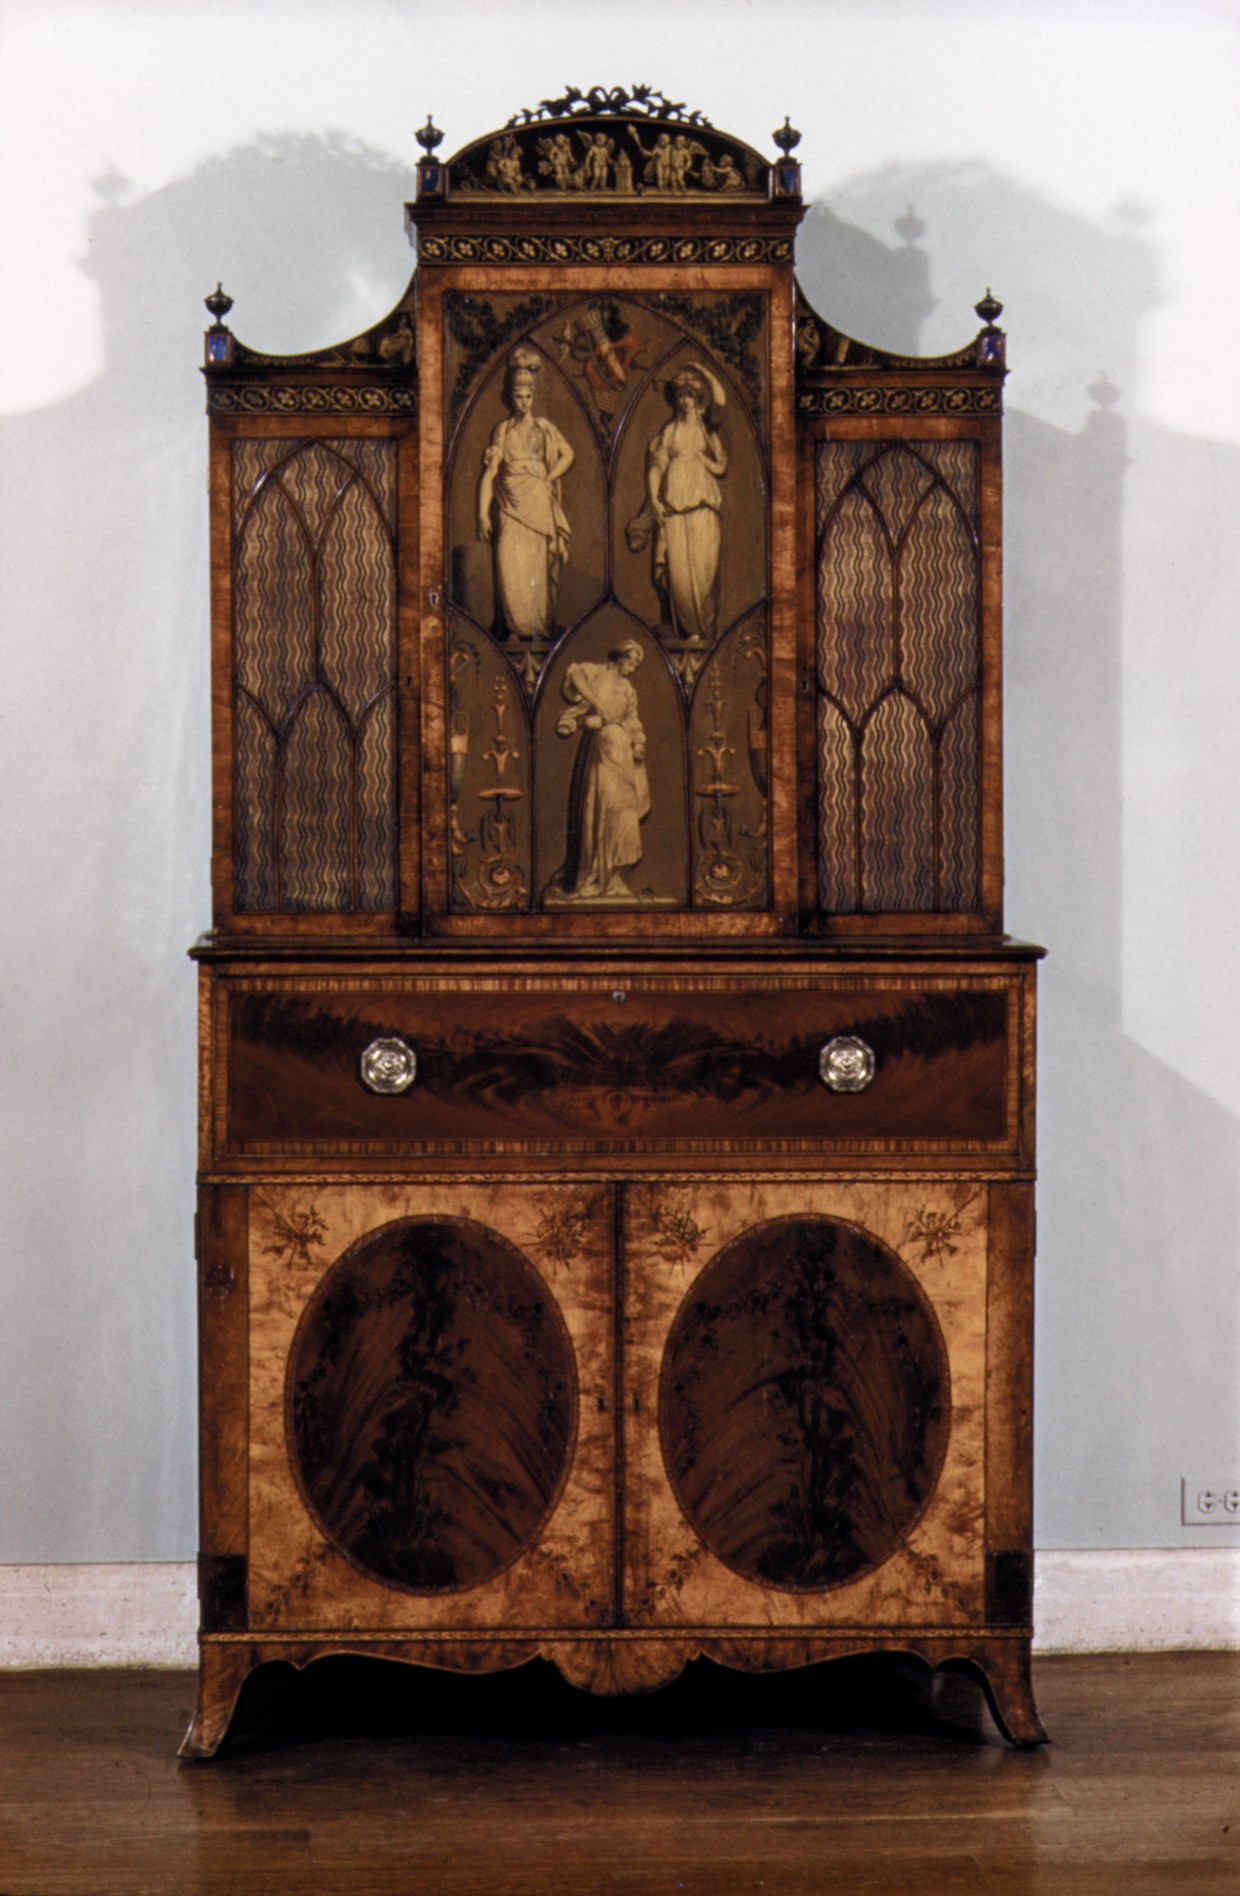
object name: secretary and bookcase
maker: joseph bramah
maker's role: lock maker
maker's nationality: british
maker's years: 1749-1814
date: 1775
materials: wood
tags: women,putti